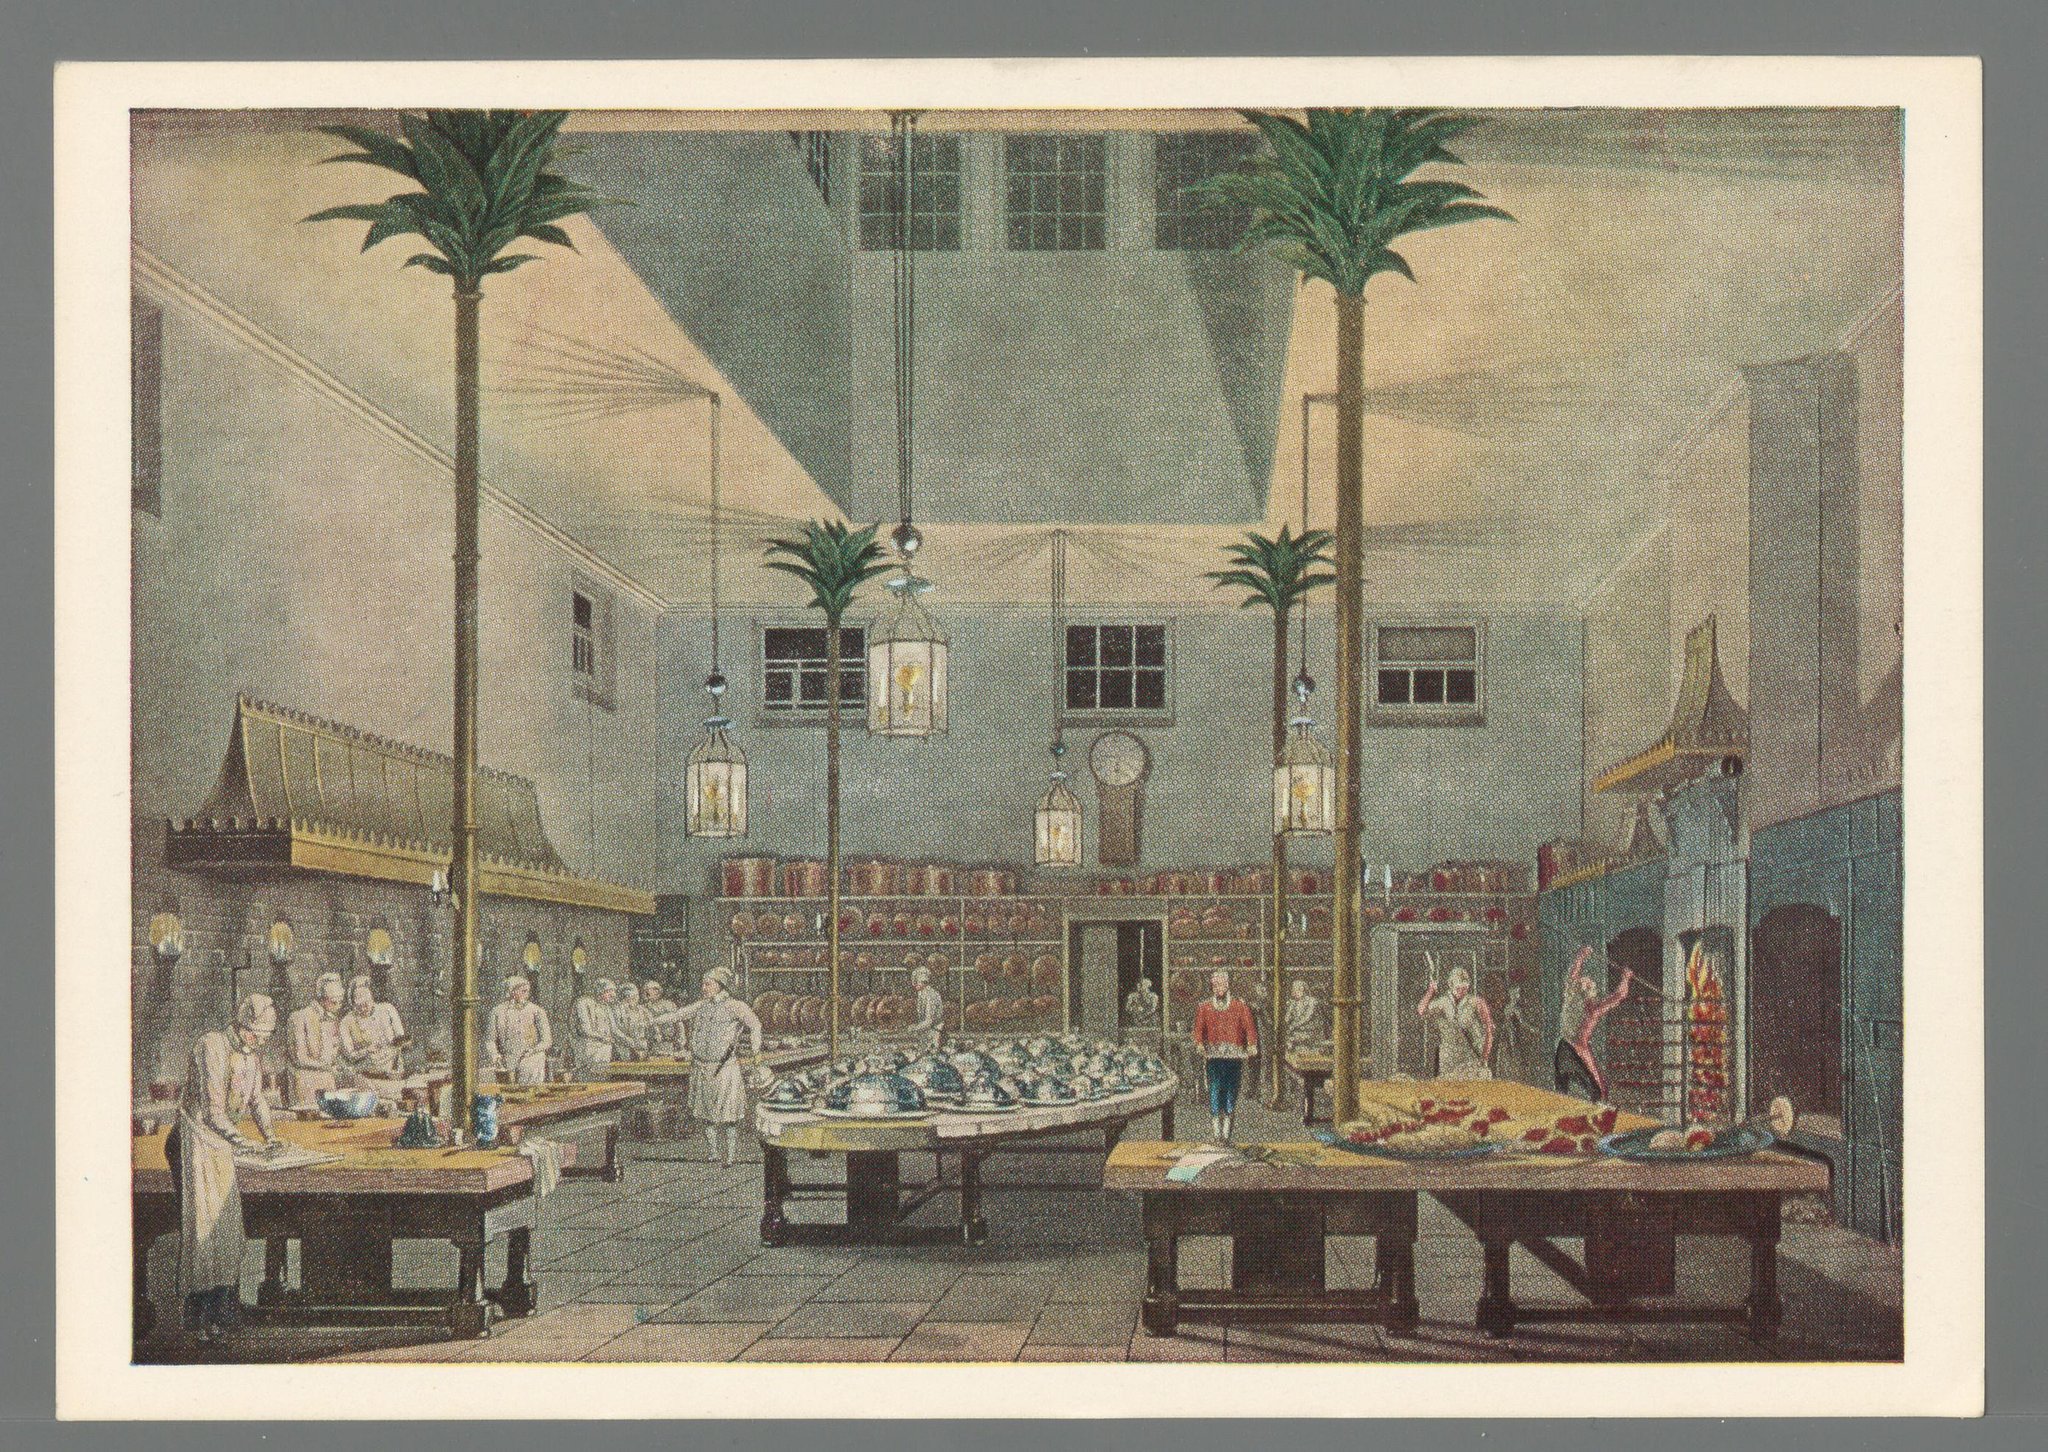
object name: photomechanical print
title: The Royal Pavilion, Brighton: The Great Kitchen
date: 1960-2020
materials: cardboard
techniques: color autotype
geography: brighton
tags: kitchen, palace